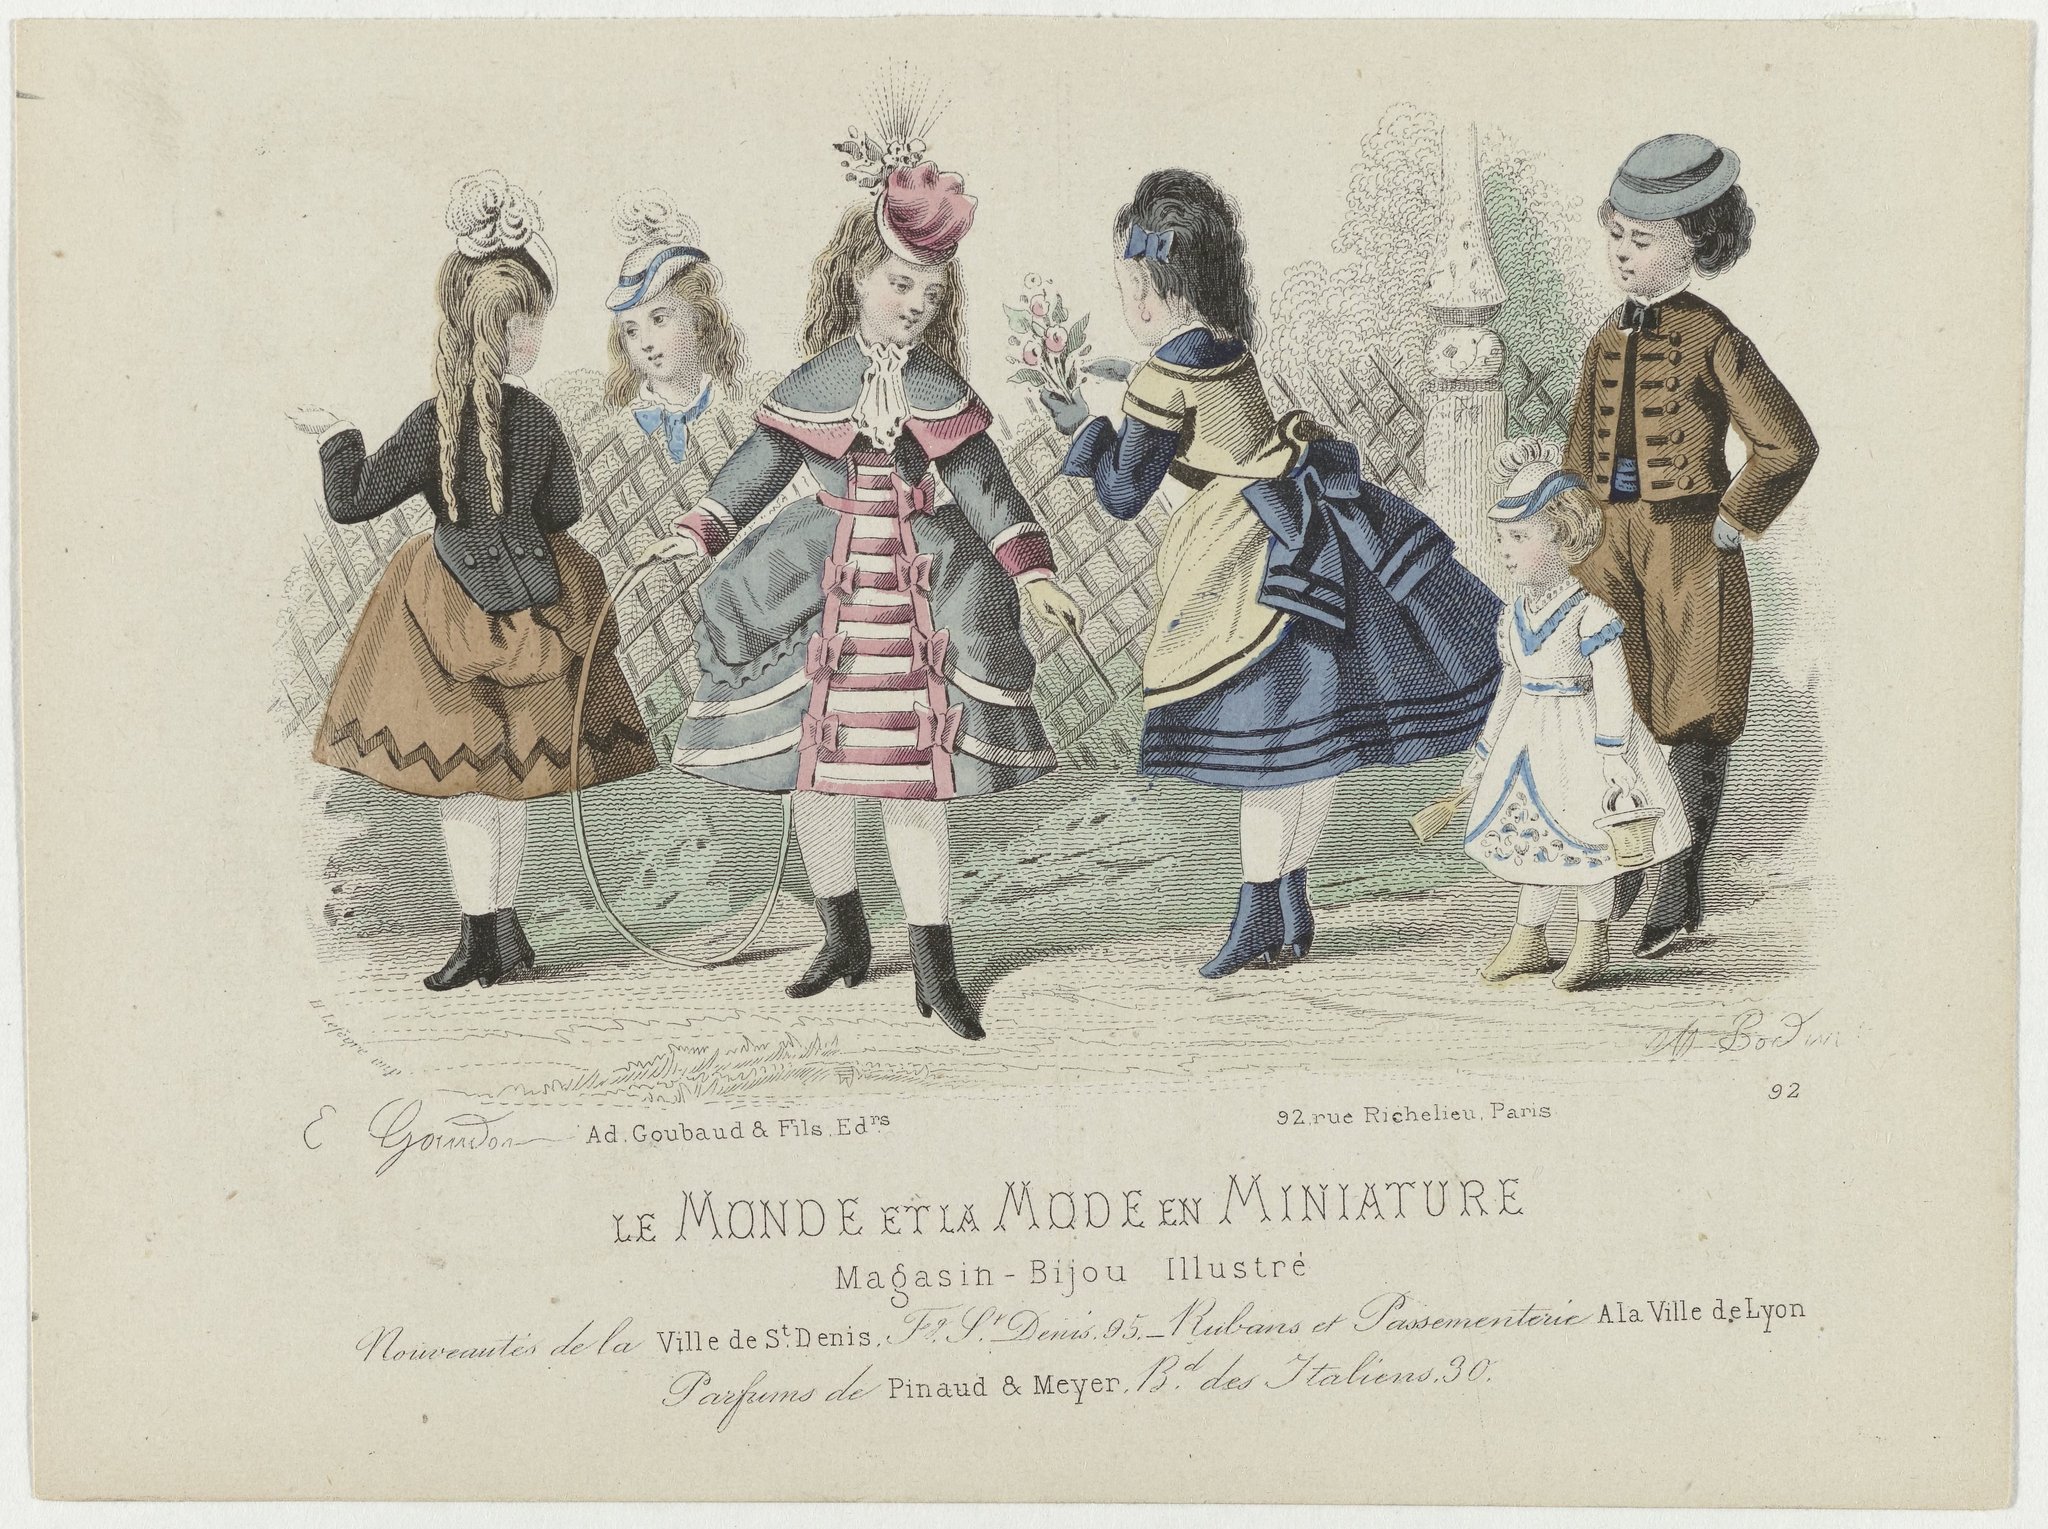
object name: fashion print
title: Le Monde et la Mode en Miniature, 1873, No. 92 : Nouveautés de la Ville de St Denis (...)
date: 1873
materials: paper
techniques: engraving, hand coloring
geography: paris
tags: skirt (+ girls' clothes), cut flowers; nosegay, bunch of flowers, boots (+ boys' clothes), trousers, breeches (+ boys' clothes), head-gear (+ girls' clothes), boots (+ girls' clothes), head-gear (+ boys' clothes), neck-gear ~ clothing (+ boys' clothes), coat (+ boys' clothes), coat (+ girls' clothes), fashion plates, (bowling a) hoop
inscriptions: caption: ‘Nouveautés de la Ville de St Denis Fg St Denis 95 _ rubans et Passementerie A la Ville de Lyon Parfums de Pinaud & Meyer Bd des Italiens 30’, title: ‘Le Monde et la Mode en Miniature / Magasin - Bijou Illustré’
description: Zes kinderen spelen buiten, de meisjjes zijn gekleed in japonnen met tournure en een mantel. De jongen draagt een jasje met een pofbroek. Het jongste kind draagt een japon met ceintuur. De kleding is van Ville de St Denis en het passement van Ville de Lyon. Prent uit het modetijdschrift Le Monde et la Mode en Miniature (1873-1874).